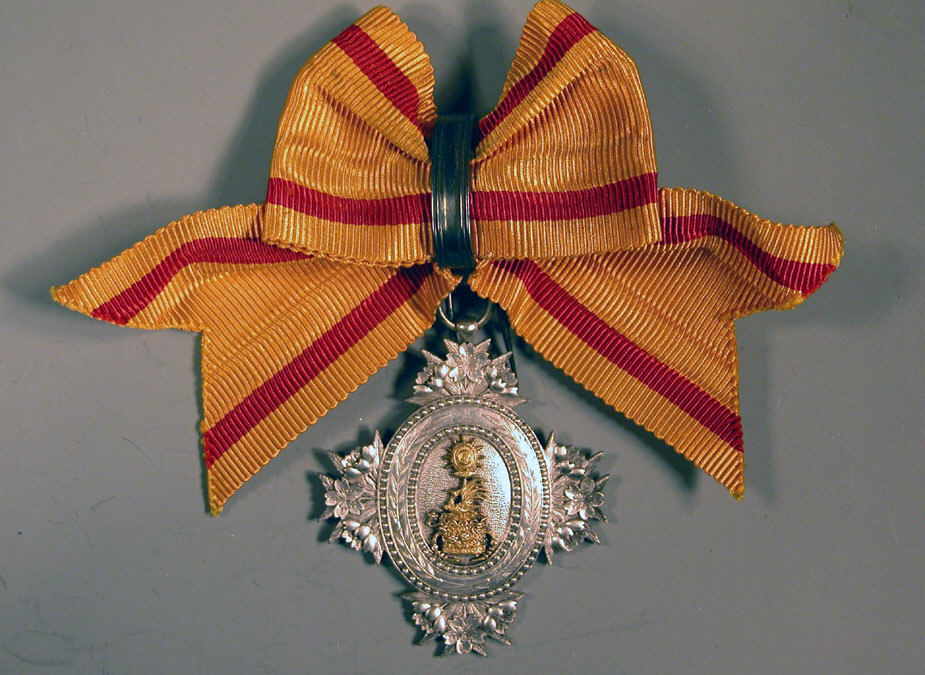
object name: medal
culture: japanese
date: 1867-1900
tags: flowers